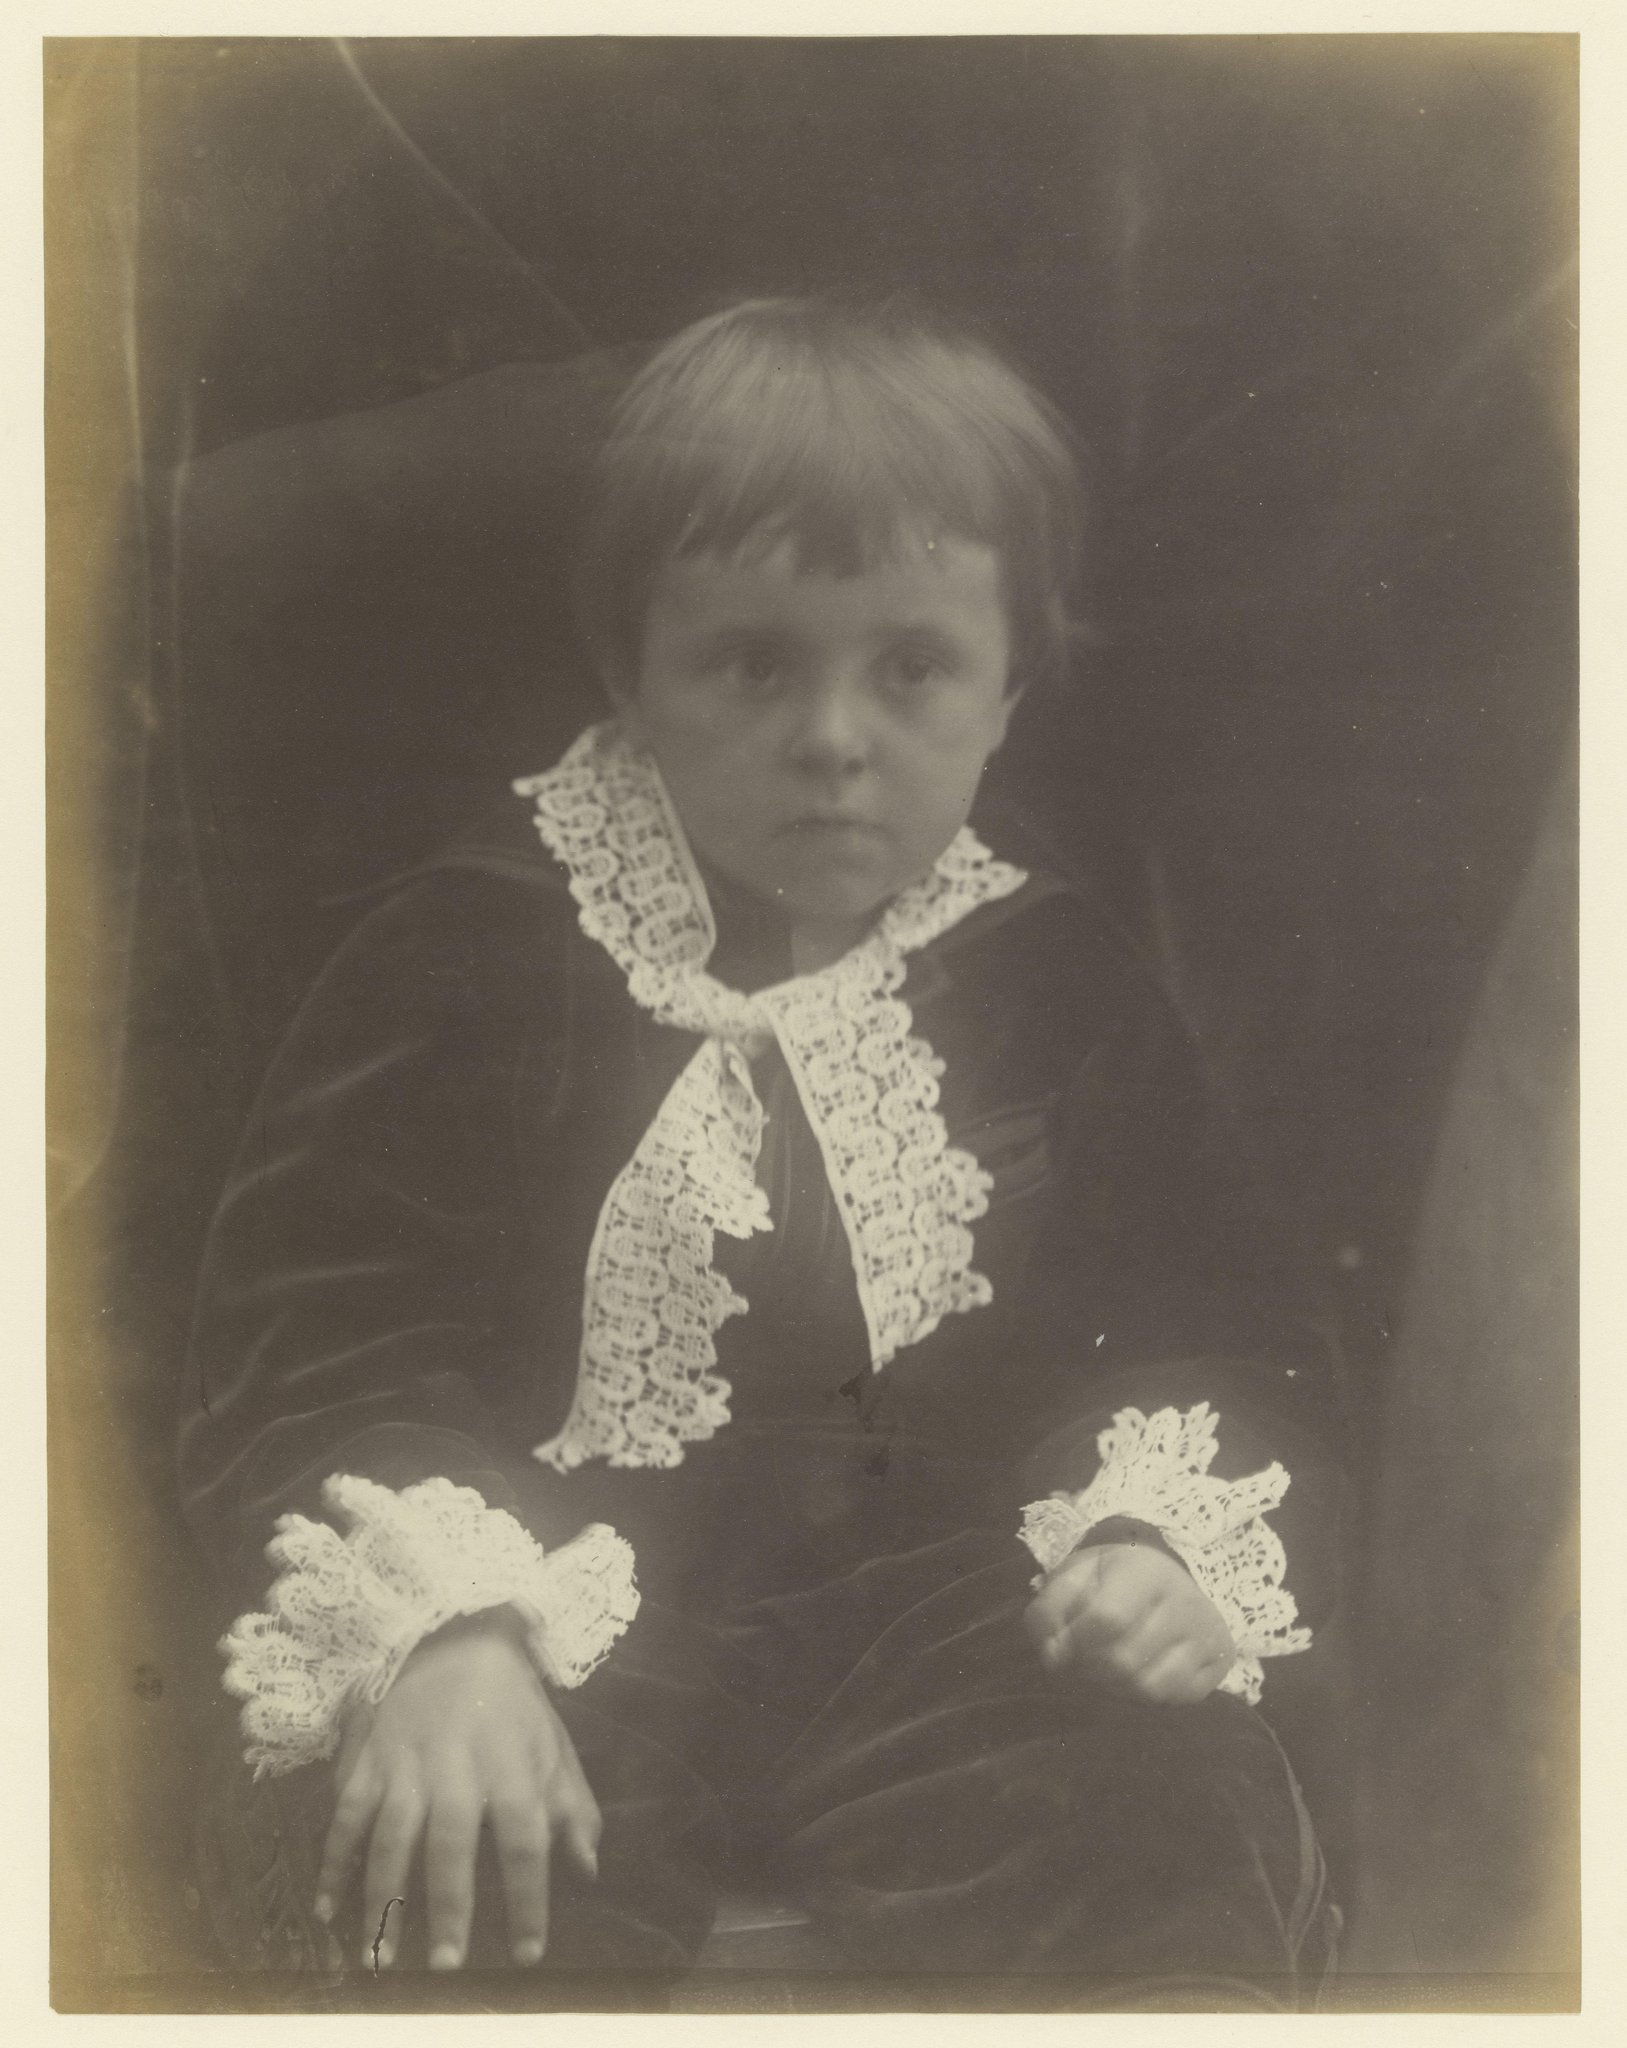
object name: photograph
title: Portret van een onbekende jongen met kanten kraag en manchetten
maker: julia margaret cameron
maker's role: fotograaf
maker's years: 1815-1879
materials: paper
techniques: albumen print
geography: great britain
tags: boy (child between toddler and youth), anonymous historical person portrayed, great britain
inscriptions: inscription: ‘JNC/ 5’, number: ‘81272’